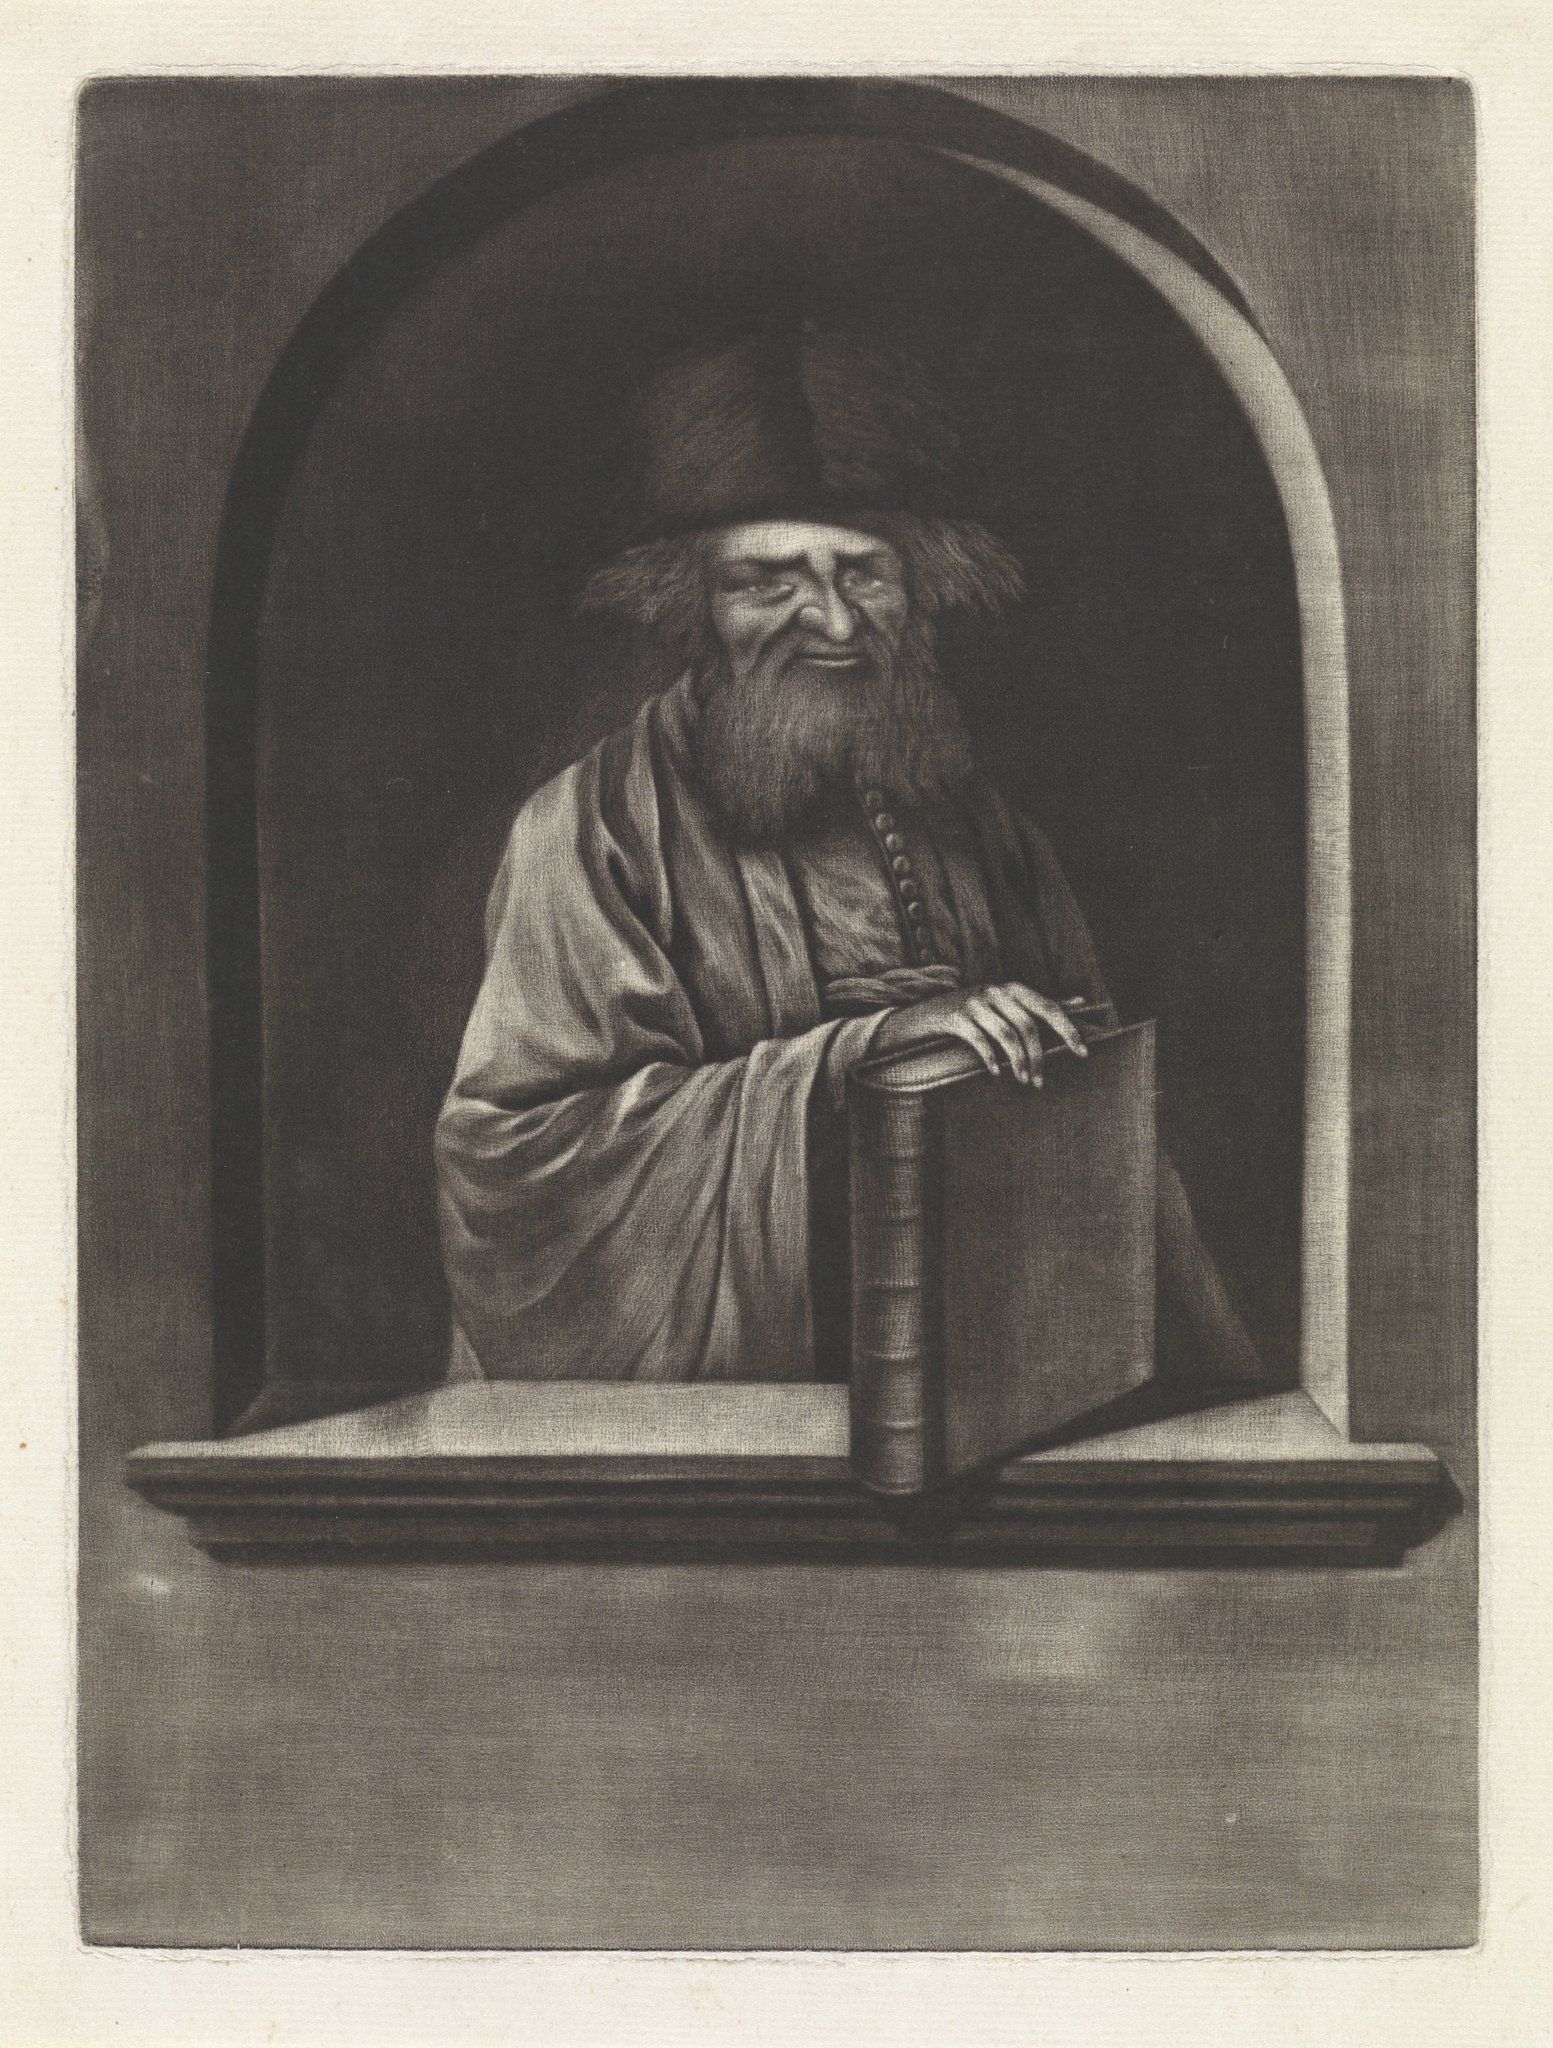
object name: print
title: Portret van Saul ben Aryeh Loeb Loewenstamm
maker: johannes craco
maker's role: print maker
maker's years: 1746-1807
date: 1771-1850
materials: paper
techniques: mezzotint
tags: amsterdam, head-gear: hat (+ men's clothes), book, rabbi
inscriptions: collector's mark: Lugt 2228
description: Portret van de rabbijn Saul ben Aryeh Loeb Loewenstamm in een venster. Zijn rechterhand rust op het boek Binjan Ariël.